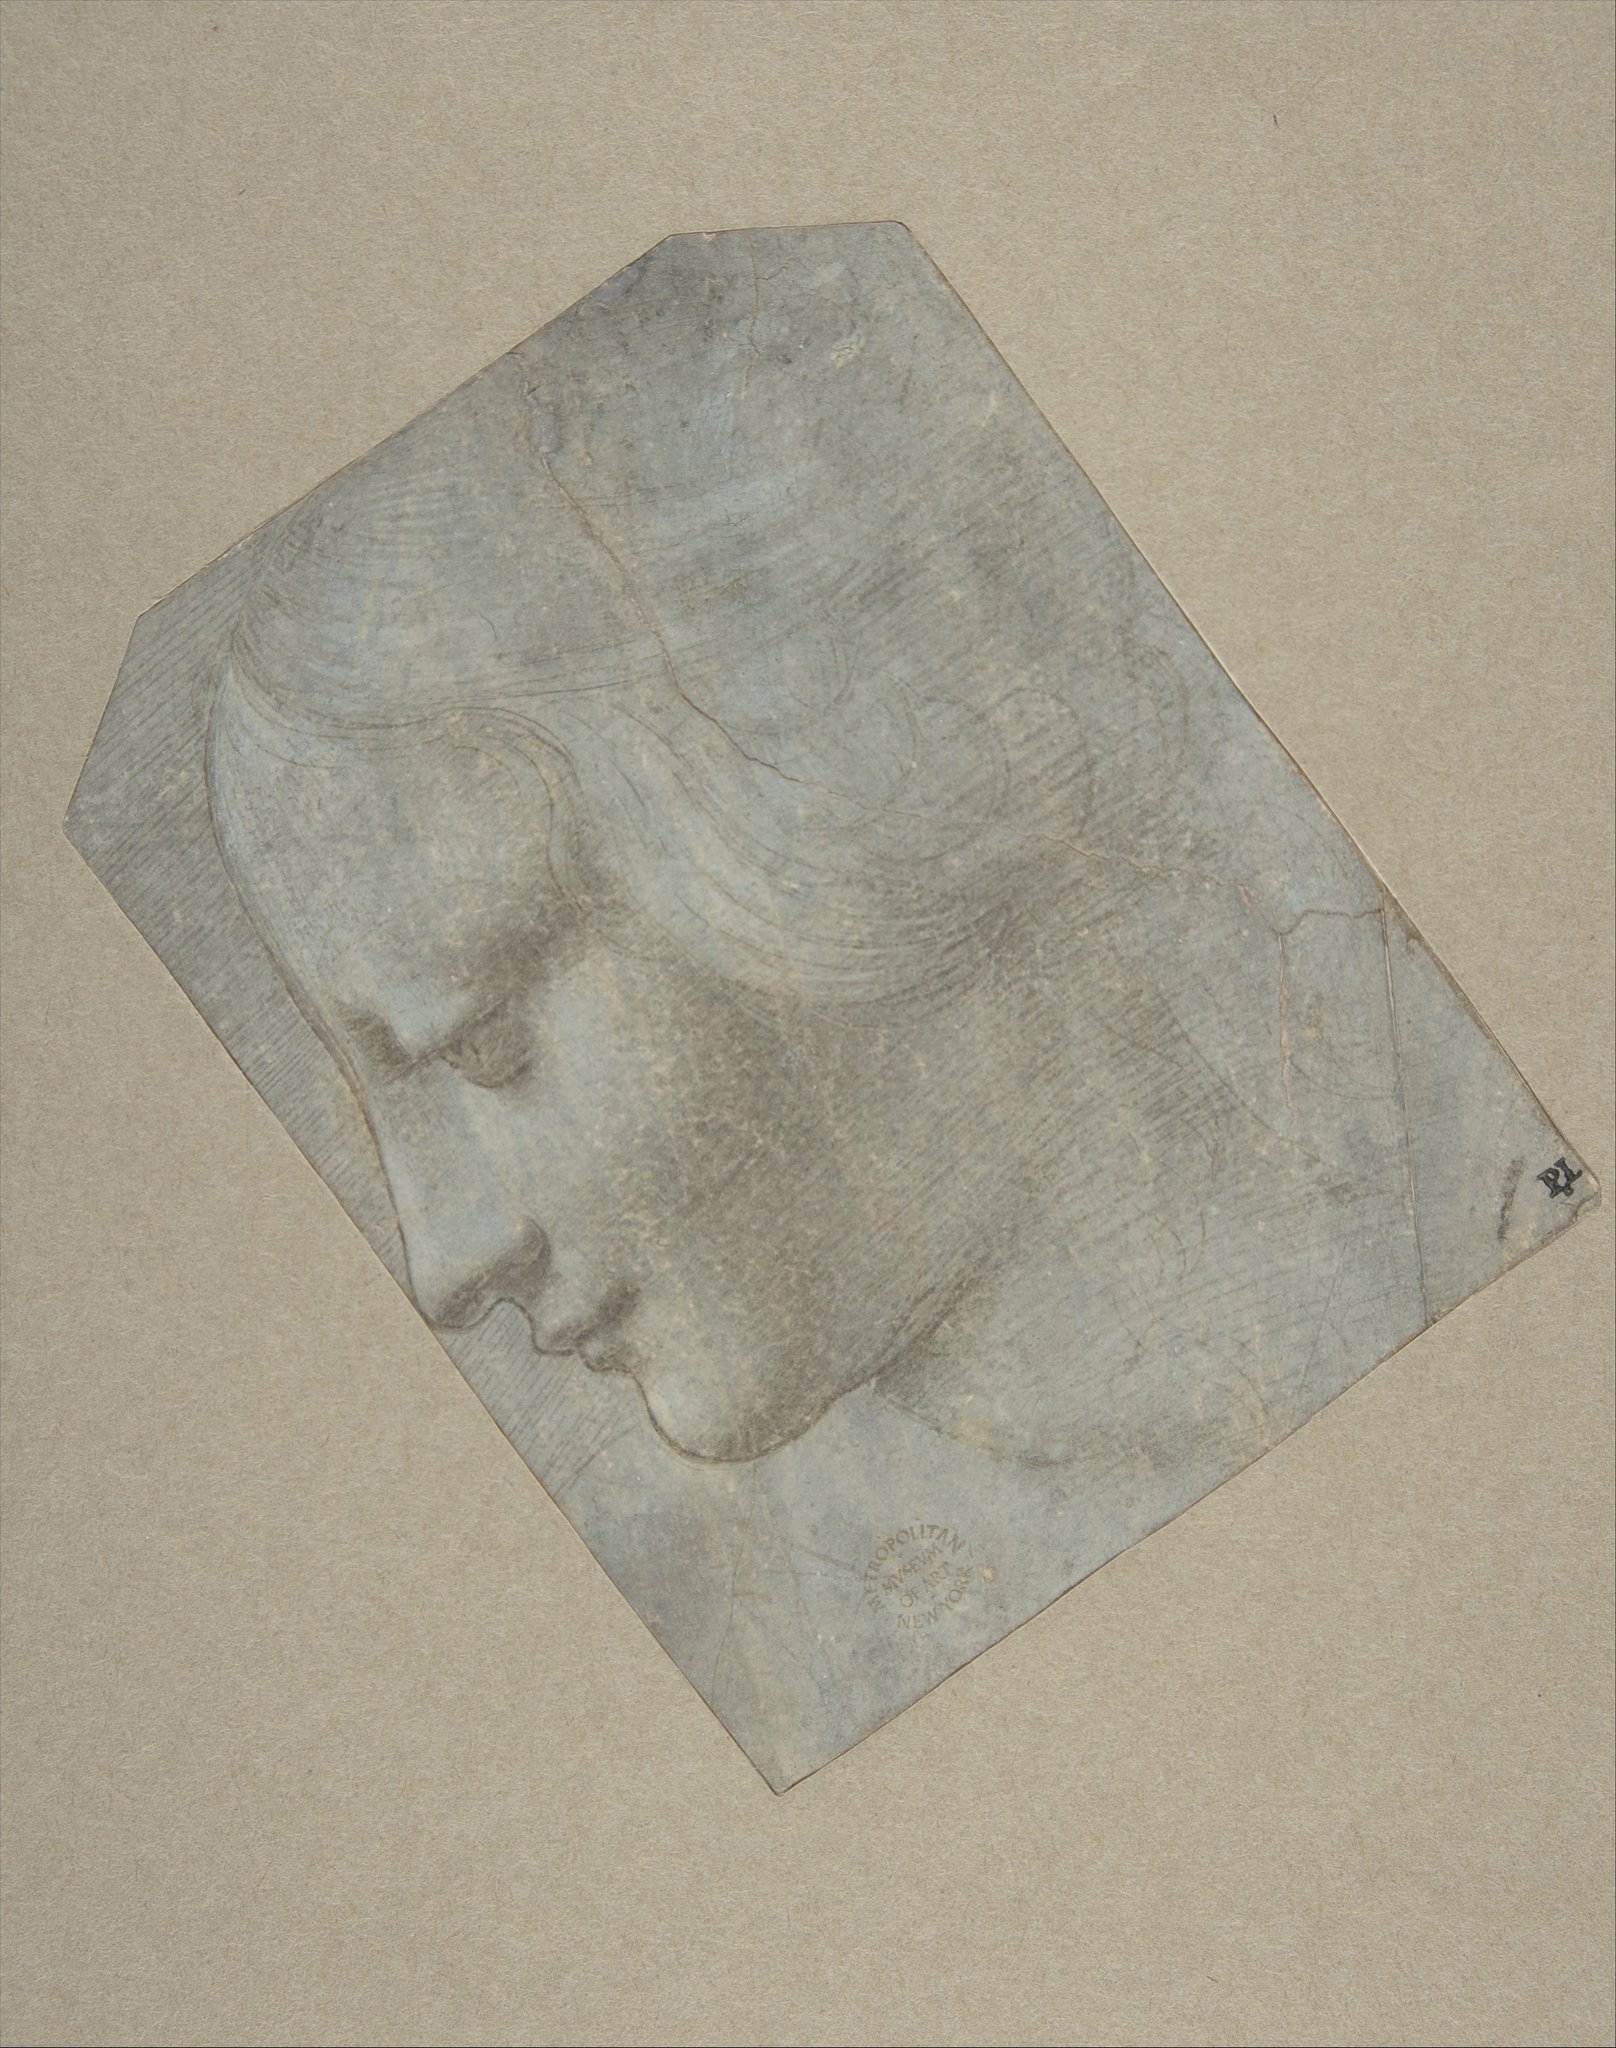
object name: drawing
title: The Head of a Woman in Profile Facing Left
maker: giovanni antonio boltraffio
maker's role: artist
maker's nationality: italian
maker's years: 1467-1516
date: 1490-1500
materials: fiber, gouache, drawing material, paper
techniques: highlighting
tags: heads,profiles,women